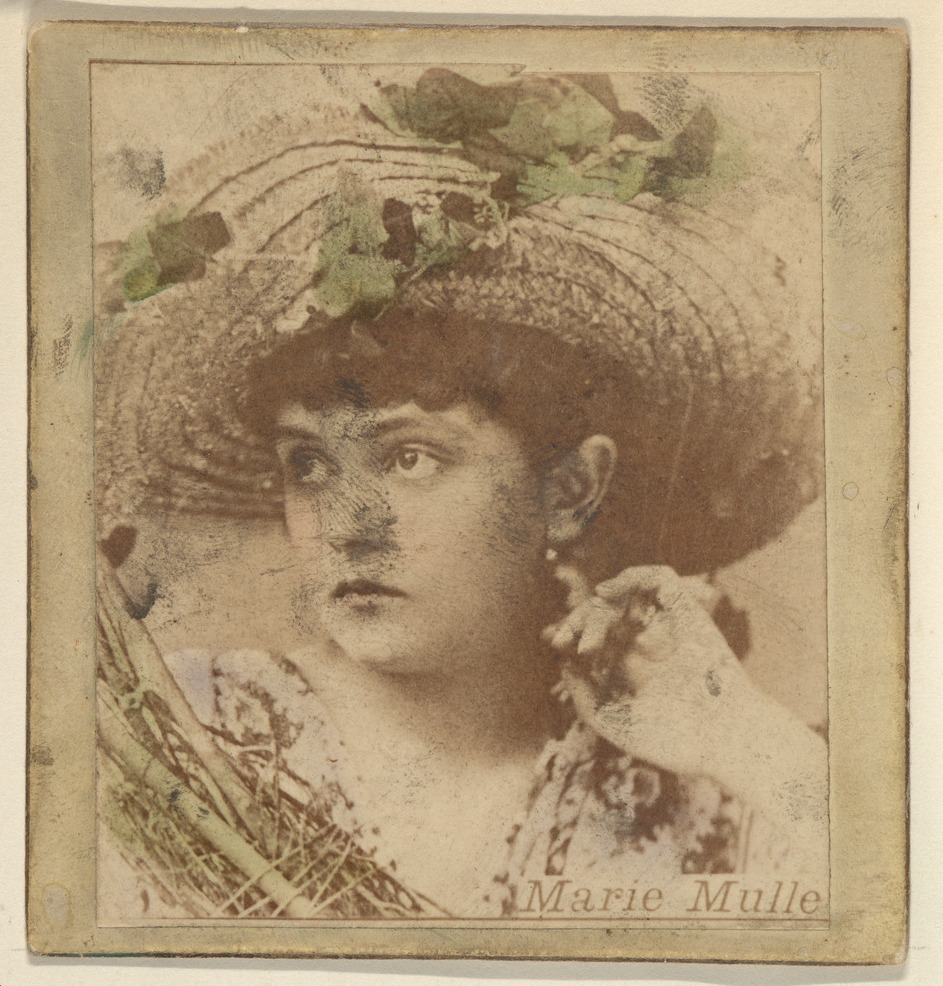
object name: photograph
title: Marie Mulle, from the Actresses series (N246), Type 2, issued by Kinney Brothers to promote Sporting Extra Cigarettes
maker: kinney brothers tobacco company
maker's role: publisher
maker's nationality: american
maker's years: 1869-2011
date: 1890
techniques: albumen silver print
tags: portraits,women,actresses